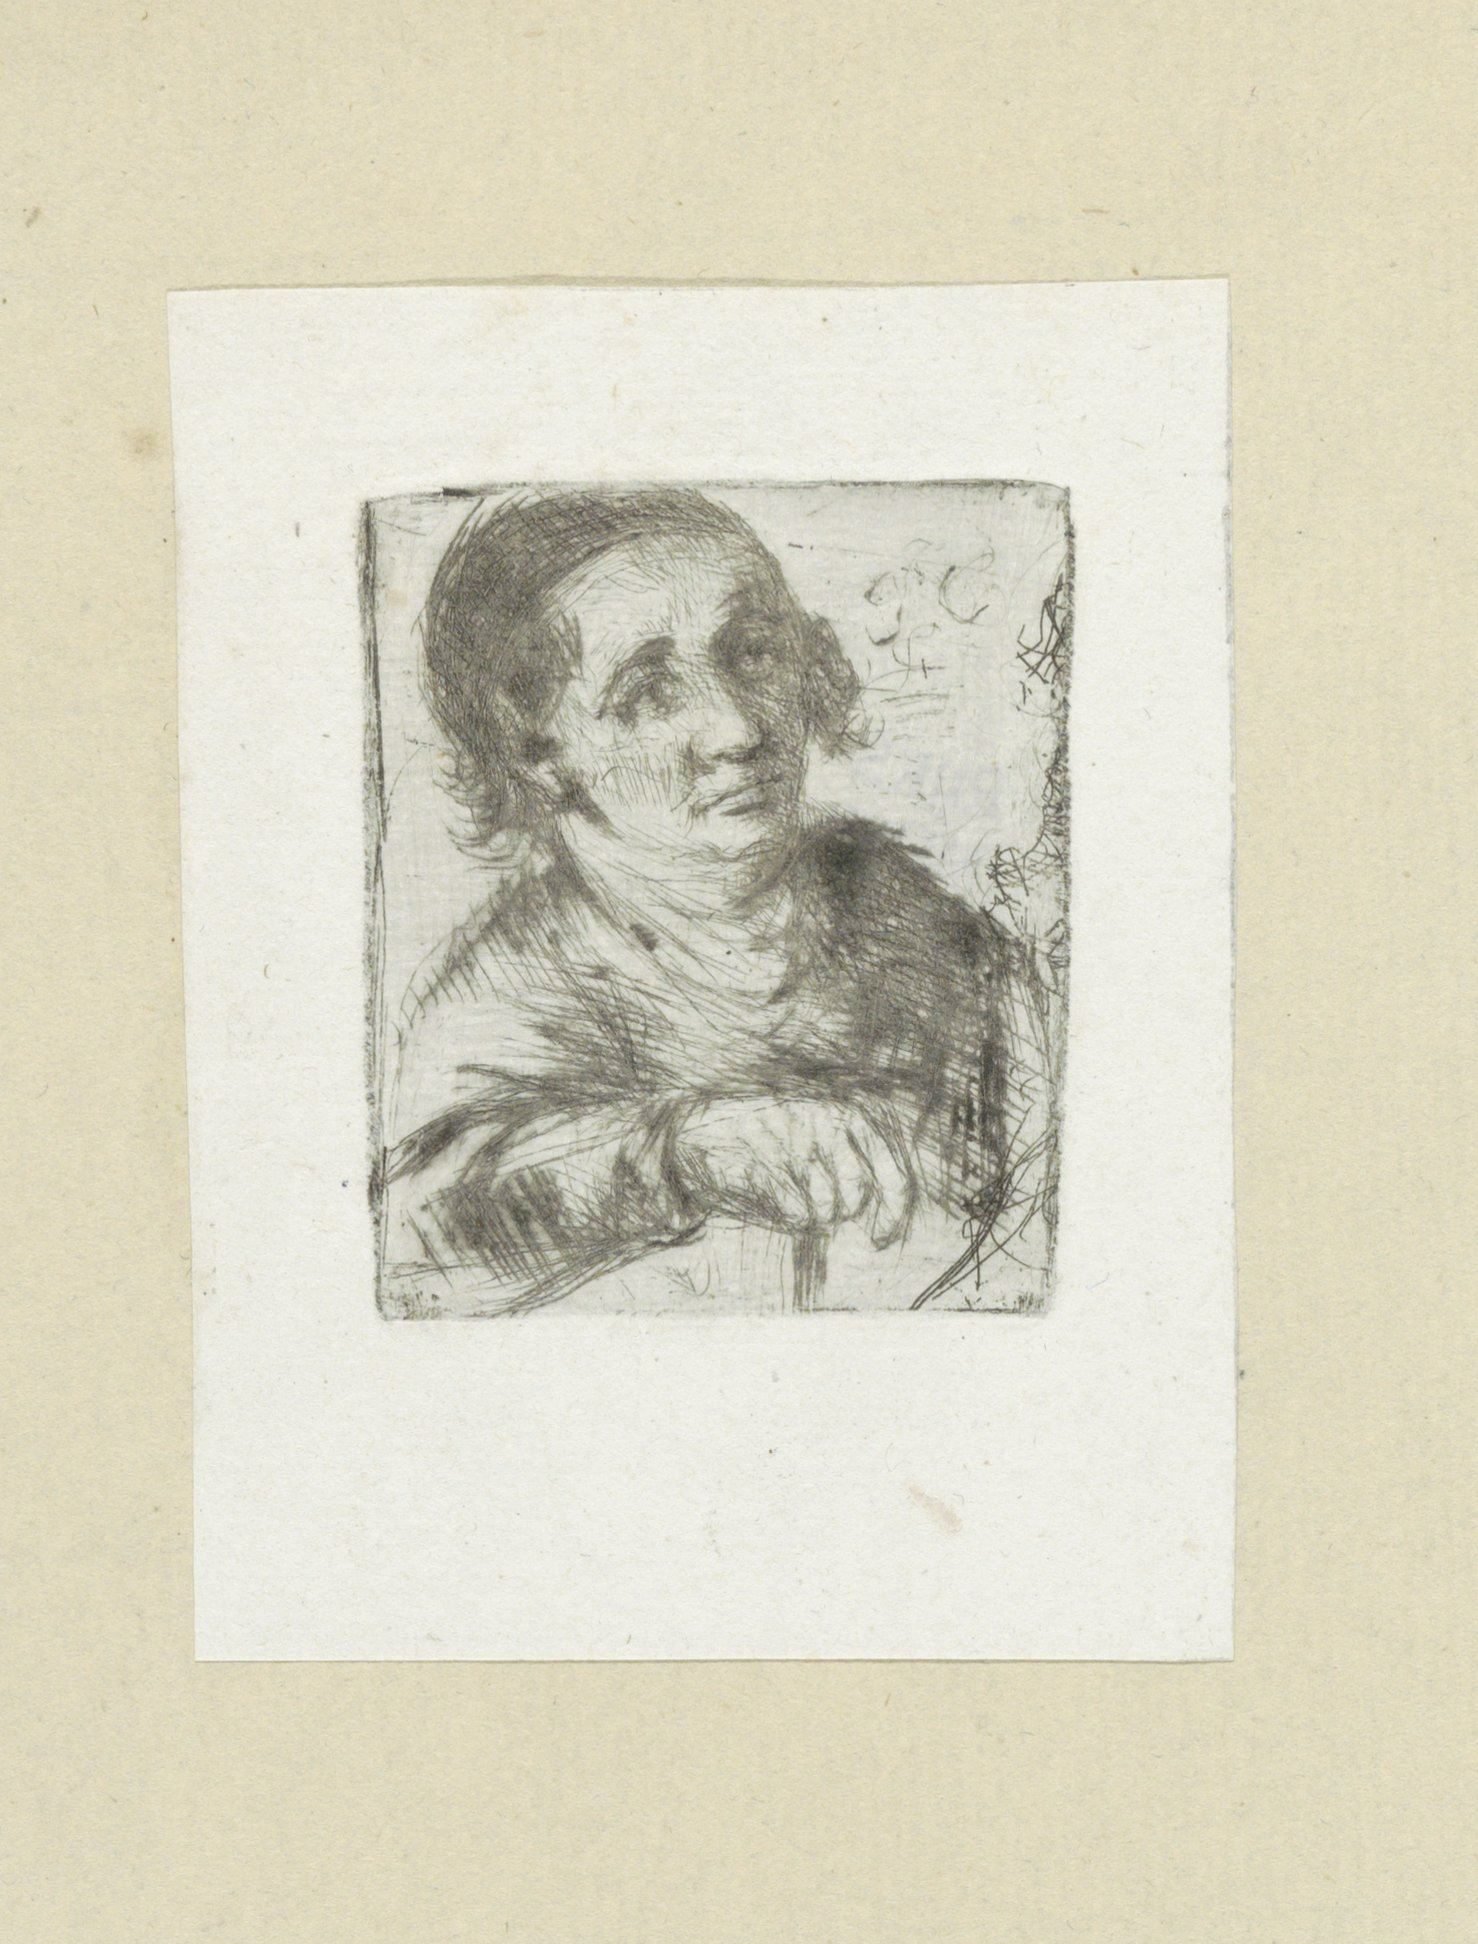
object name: album leaf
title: The Compleat Work of Etchings by John Chalon / Oeuvre Complette des Eaux Fortes par Jean Chalon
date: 1802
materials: paper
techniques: drypoint, etching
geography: london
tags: morphology of human expression (+ adult male (human being))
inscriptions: collector's mark: ‘RIJKS / MUSM’, collector's mark: ‘B’